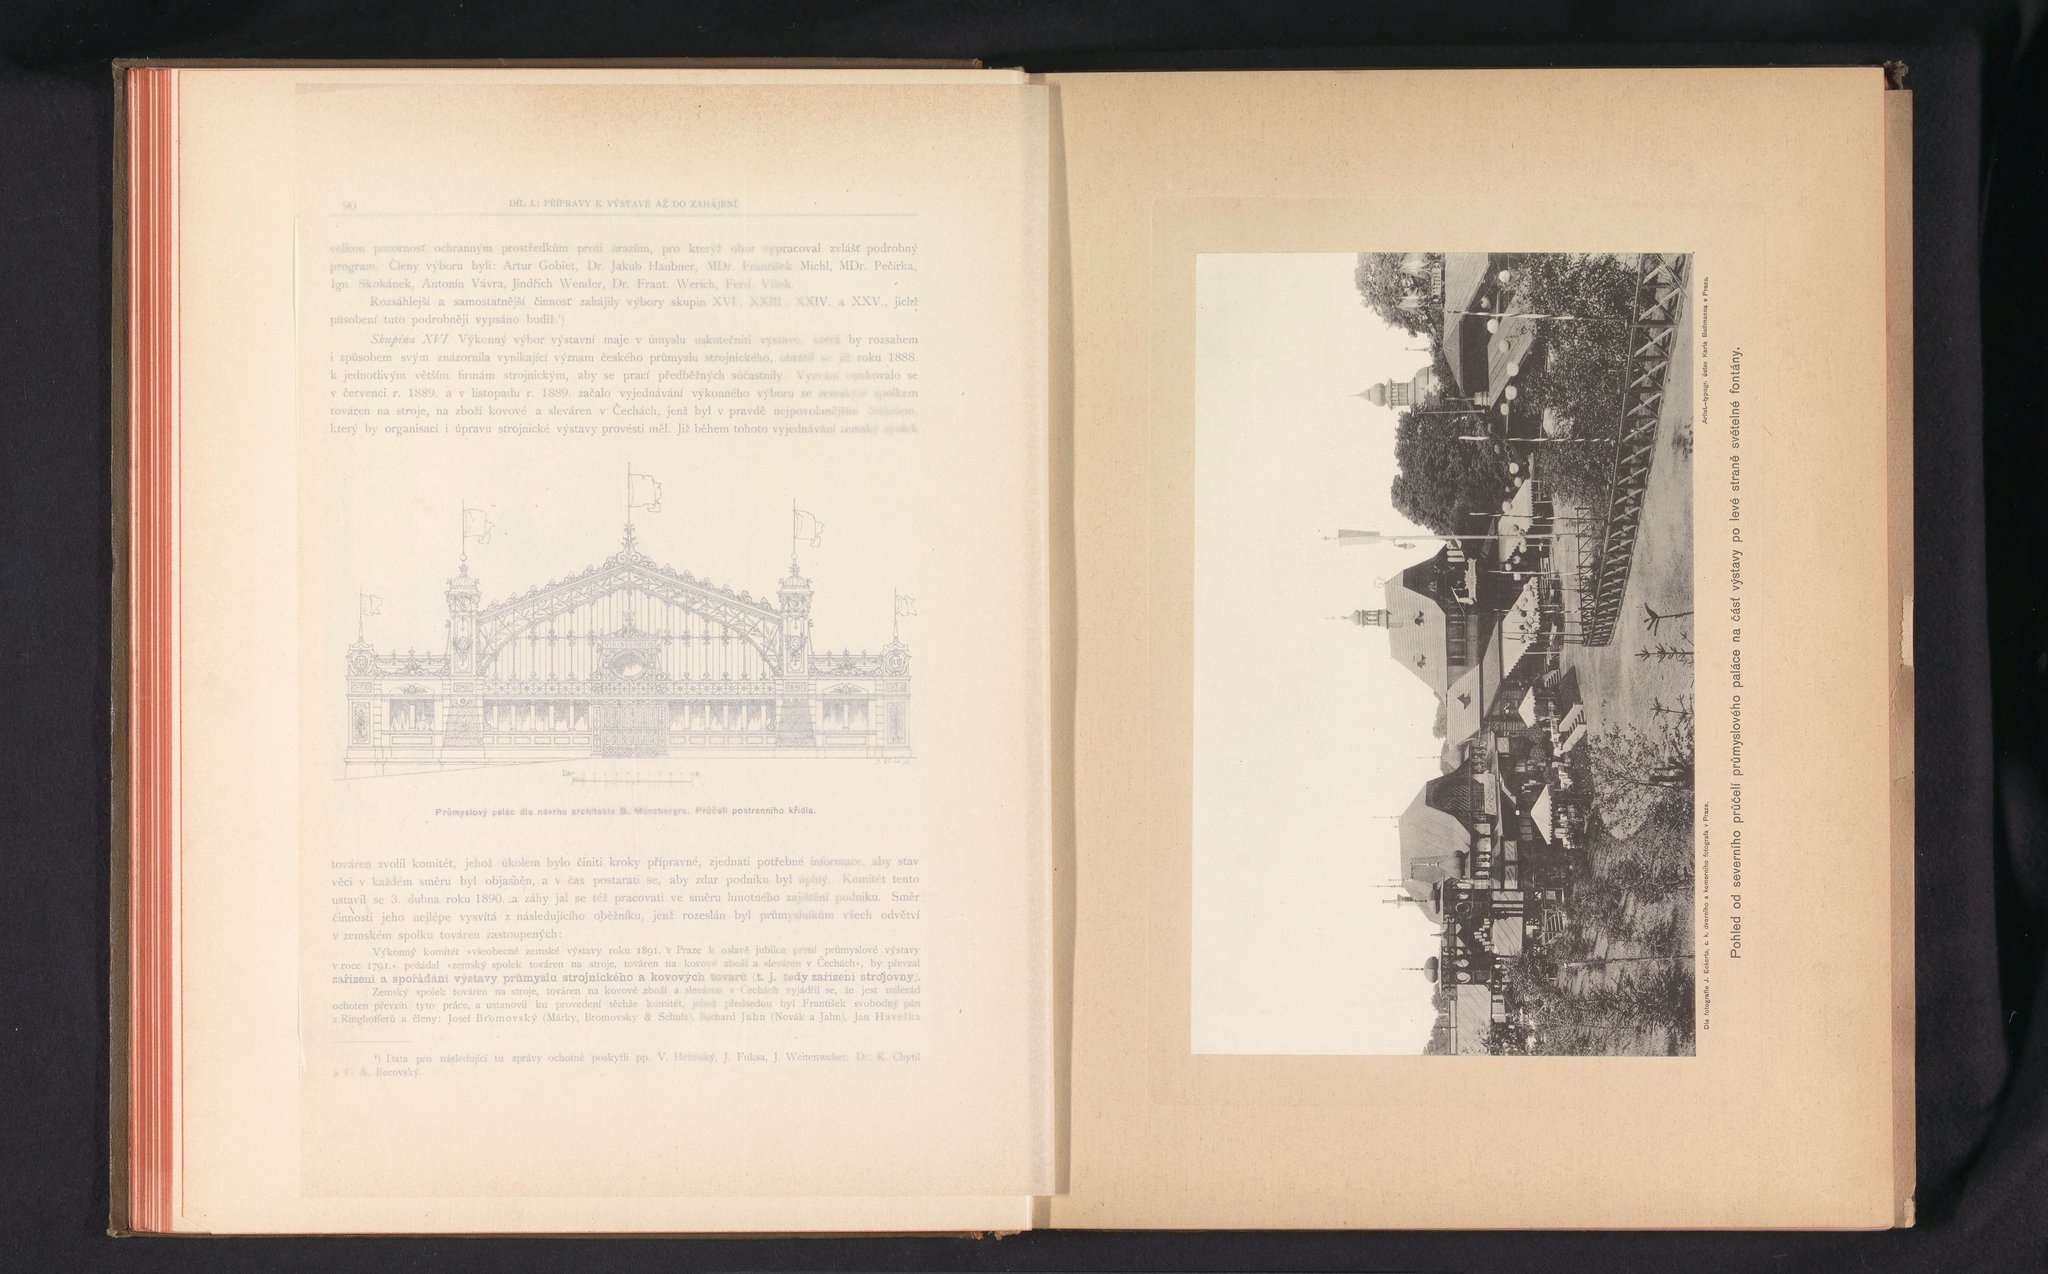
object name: photomechanical print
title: Pohled od severniho pruceli prumyslového paláce na cást výstavy po levé straně světelné fontány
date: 1888-1893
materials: paper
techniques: photograph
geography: prague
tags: temporary exhibition, 'salon'